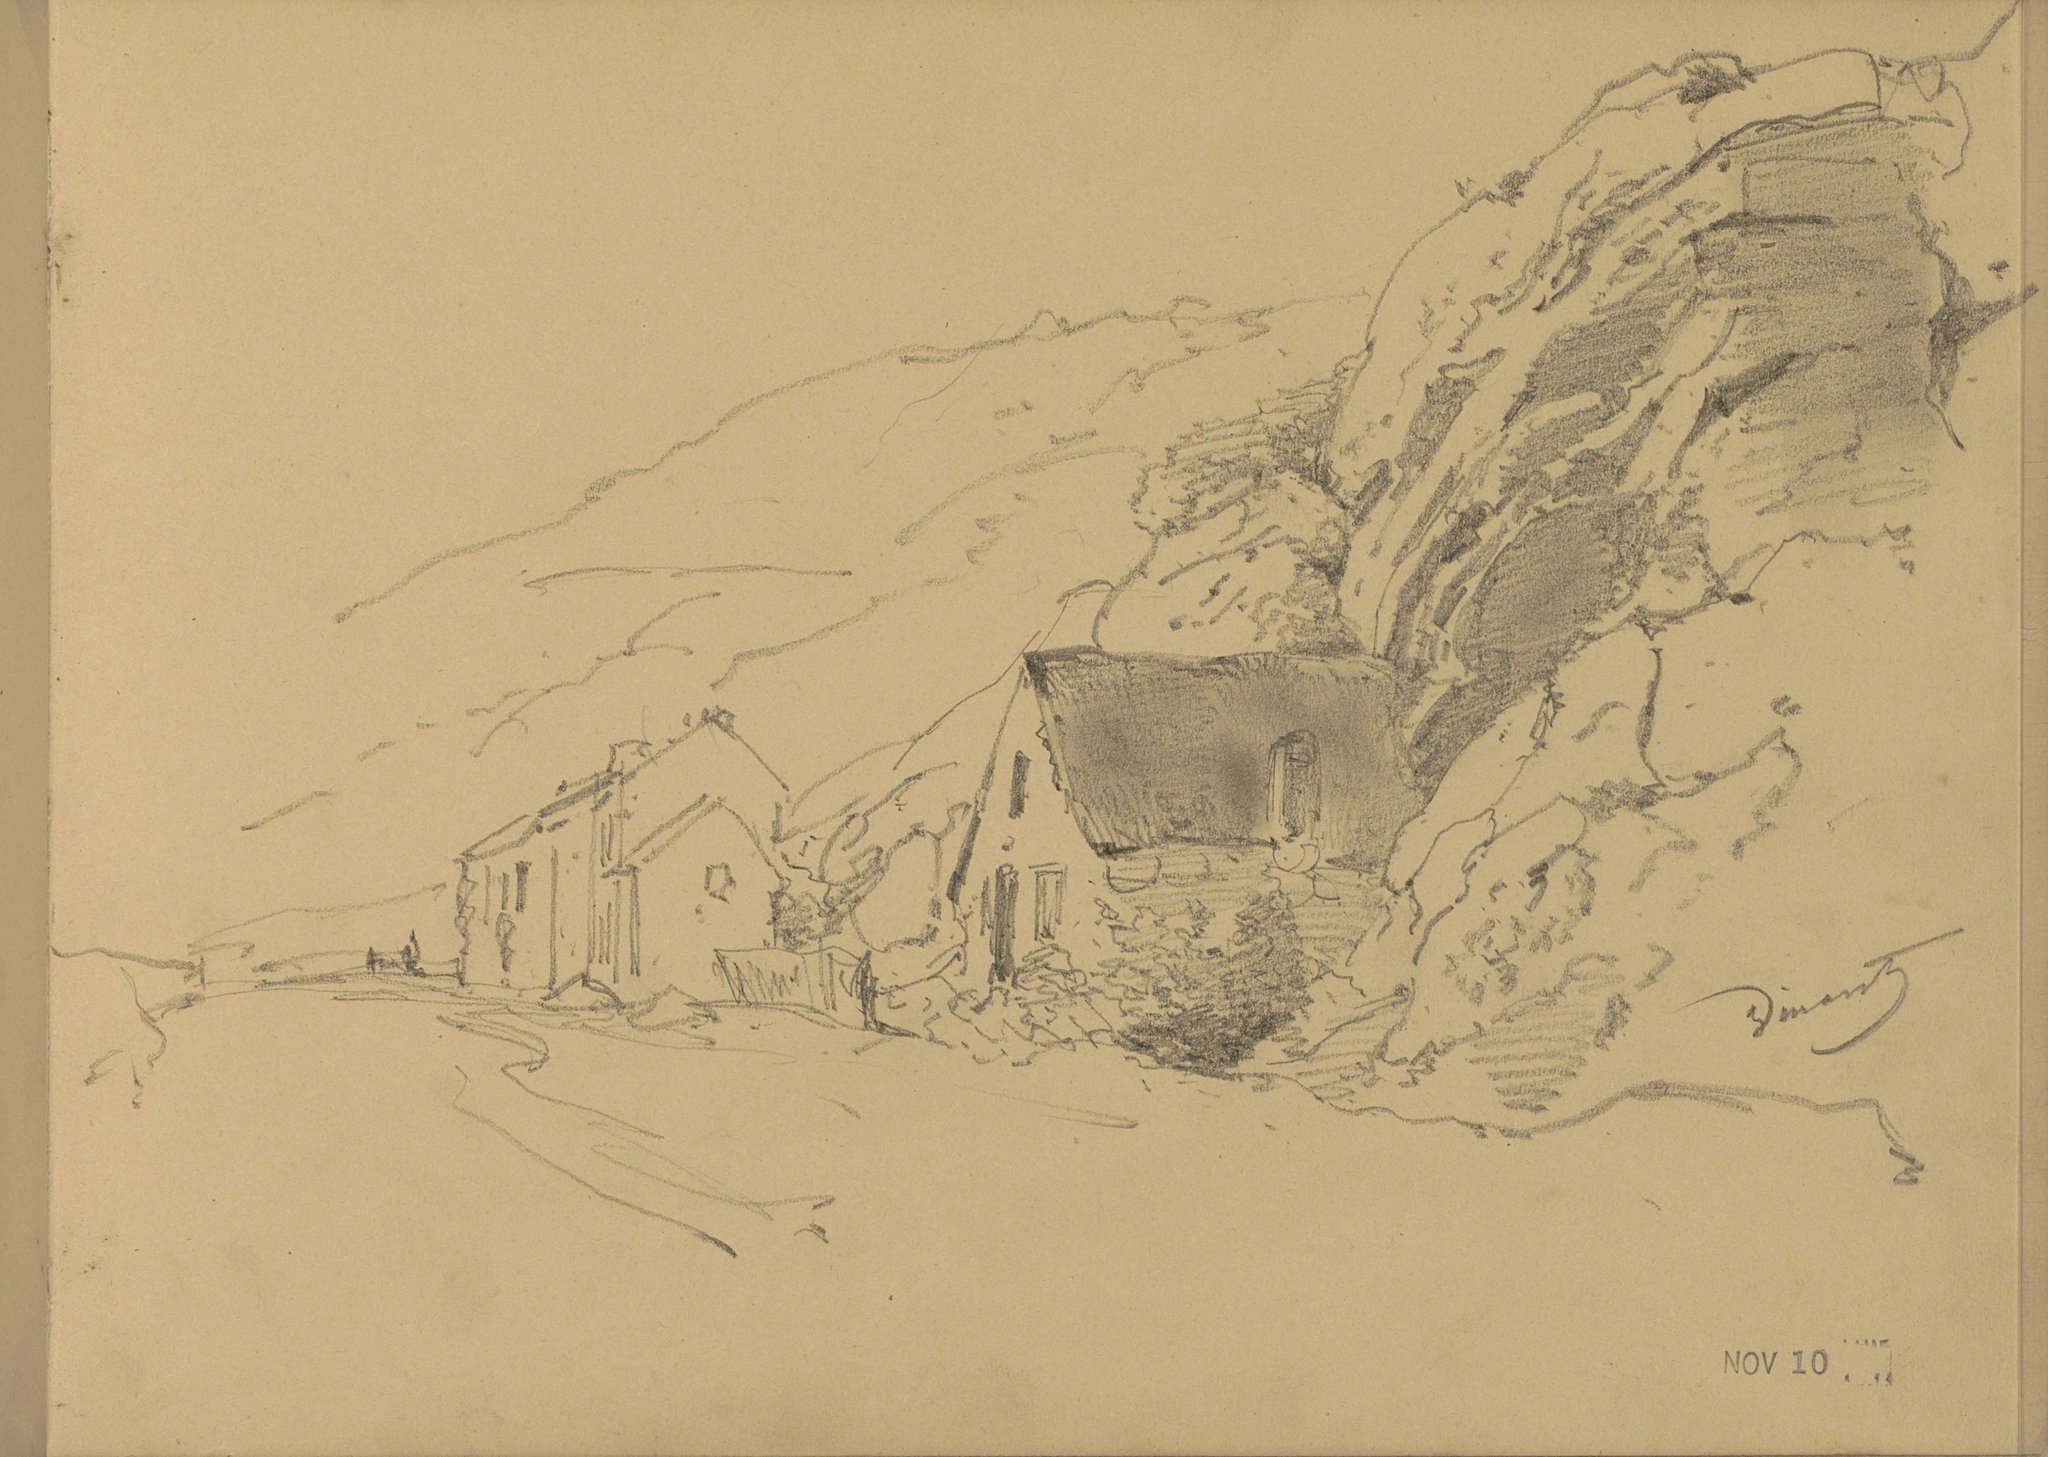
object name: sketchbook leaf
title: Huizen te Dinant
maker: willem roelofs (i)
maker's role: draughtsman, painter, print maker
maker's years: 1822-1897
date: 1846-1851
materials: paper, pencil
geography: dinant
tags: prospect of village, silhouette of village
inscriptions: annotation: ‘Dinant’, date: ‘NOV 10 , ,,’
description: Blad 5 recto uit een schetsboek met 25 bladen.